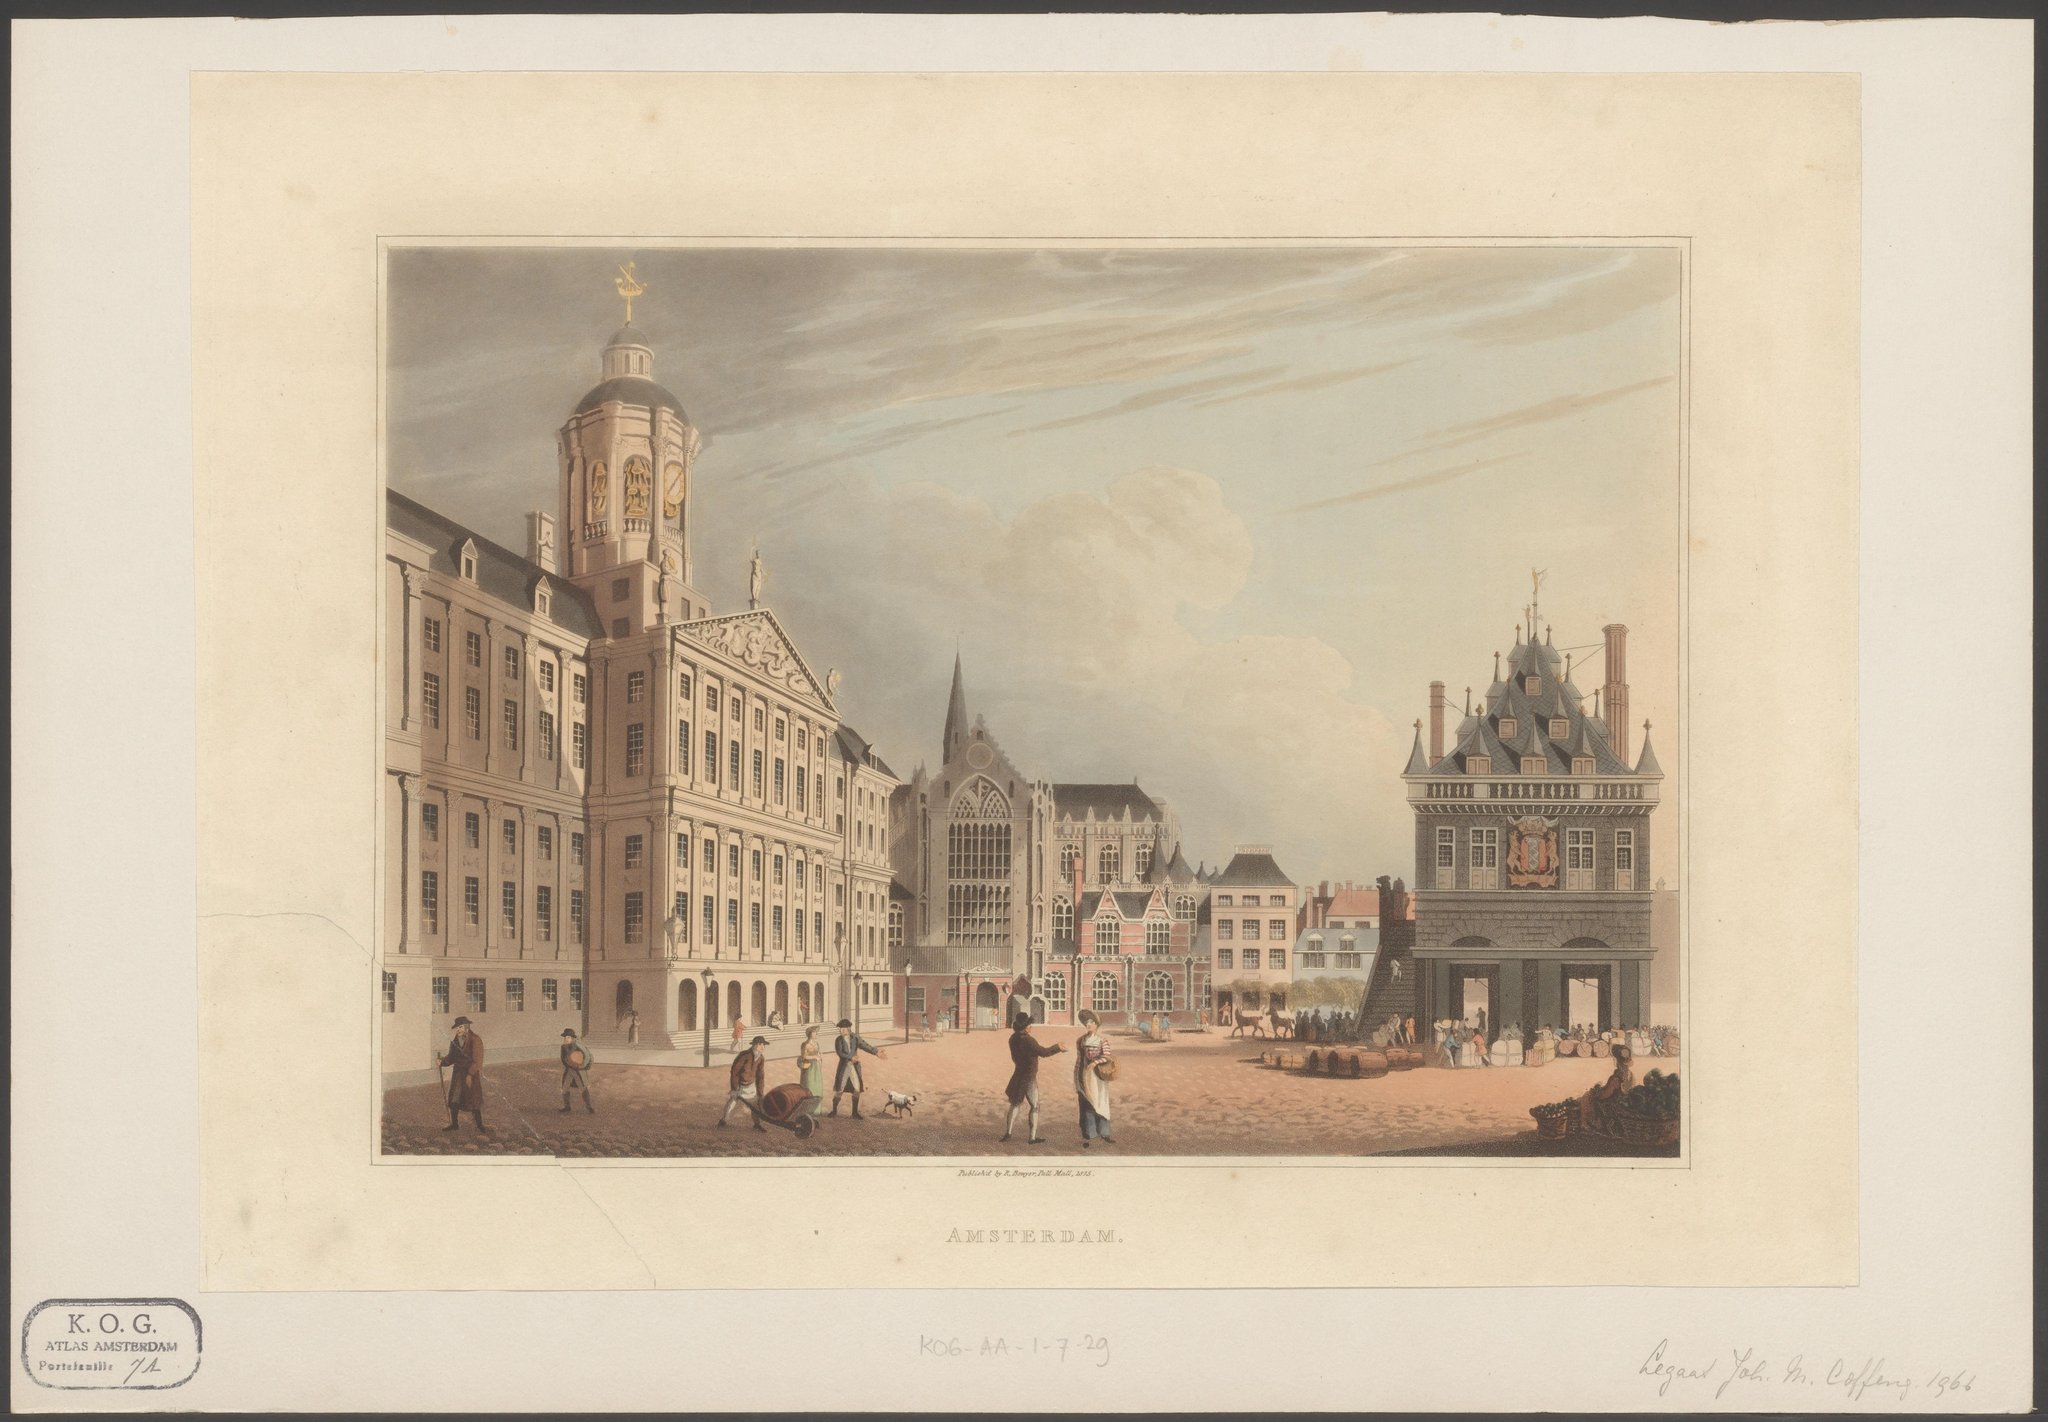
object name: print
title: Gezicht op het Stadhuis, de Nieuwe Kerk en de Waag op de Dam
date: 1815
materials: paper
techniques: aquatint, etching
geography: amsterdam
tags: square, place, circus, etc., city-view in general; 'veduta', townhall, weigh-house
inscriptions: inscription: ‘Legaat Joh. M. Coffeng. 1966’, collector's mark: ‘7A’ Lugt 1641b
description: Onderwerpsrubriek binnen de Atlas Amsterdam: Dam (voor 1835).